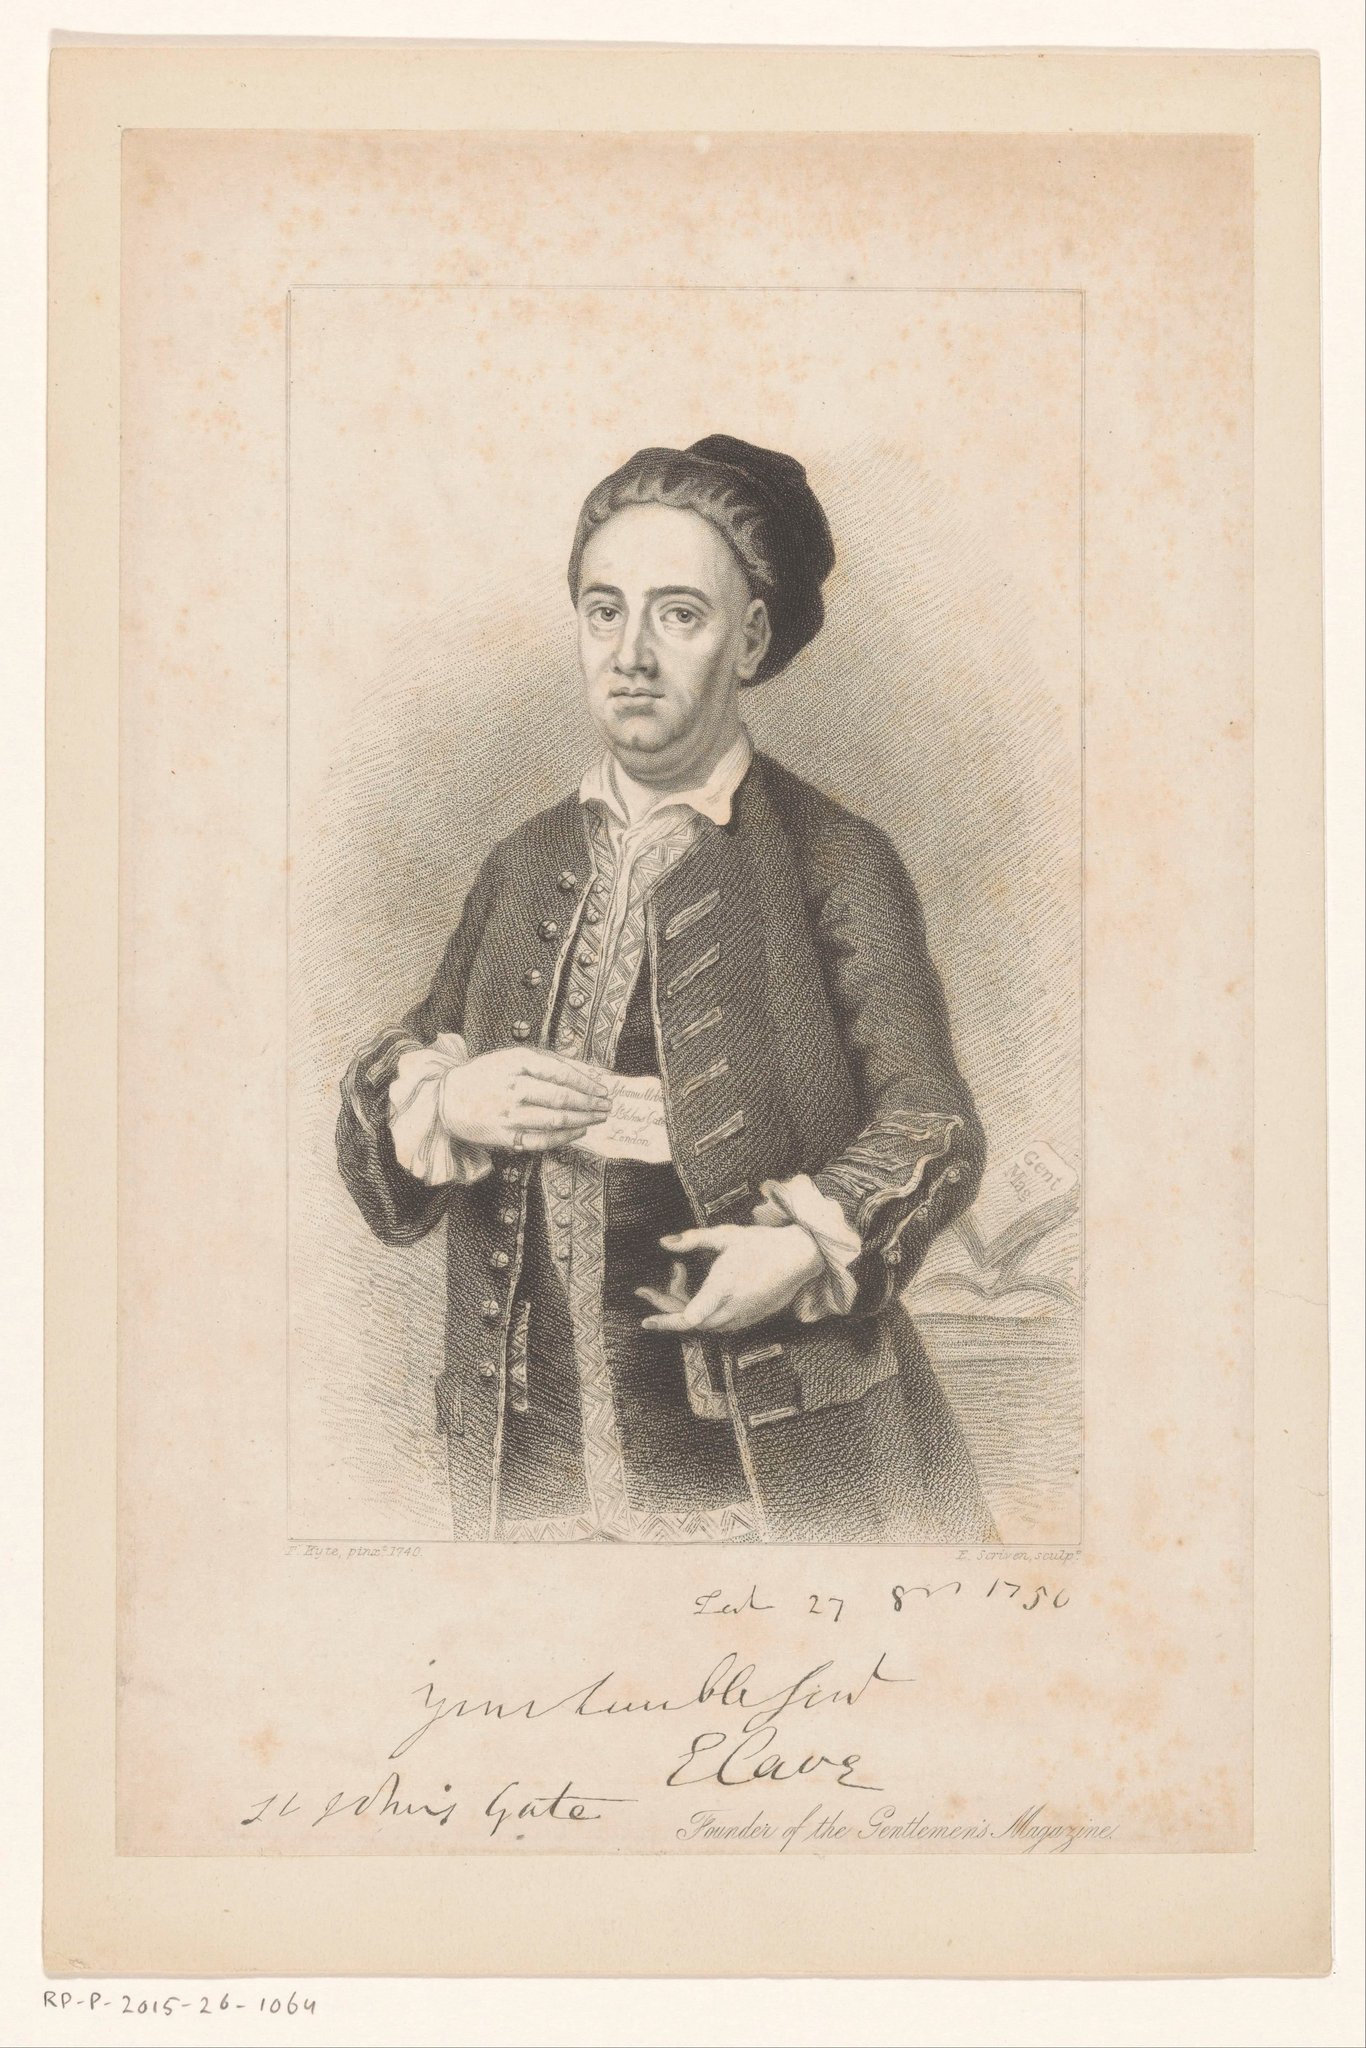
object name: print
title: Founder of the Gentlemen's Magazine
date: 1835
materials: paper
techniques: etching, roulette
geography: london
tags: edward cave, publishing, publisher, printer, letter, envelope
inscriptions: collector's mark: Lugt 4779, collector's mark: Lugt 2228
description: Portret van uitgever en drukker Edward Cave in achttiende-eeuwse kleding. Met zijn rechterhand haalt hij een brief uit zijn binnenzak. Onder het portret een reproductie van zijn handtekening en adres, gedateerd 1750.